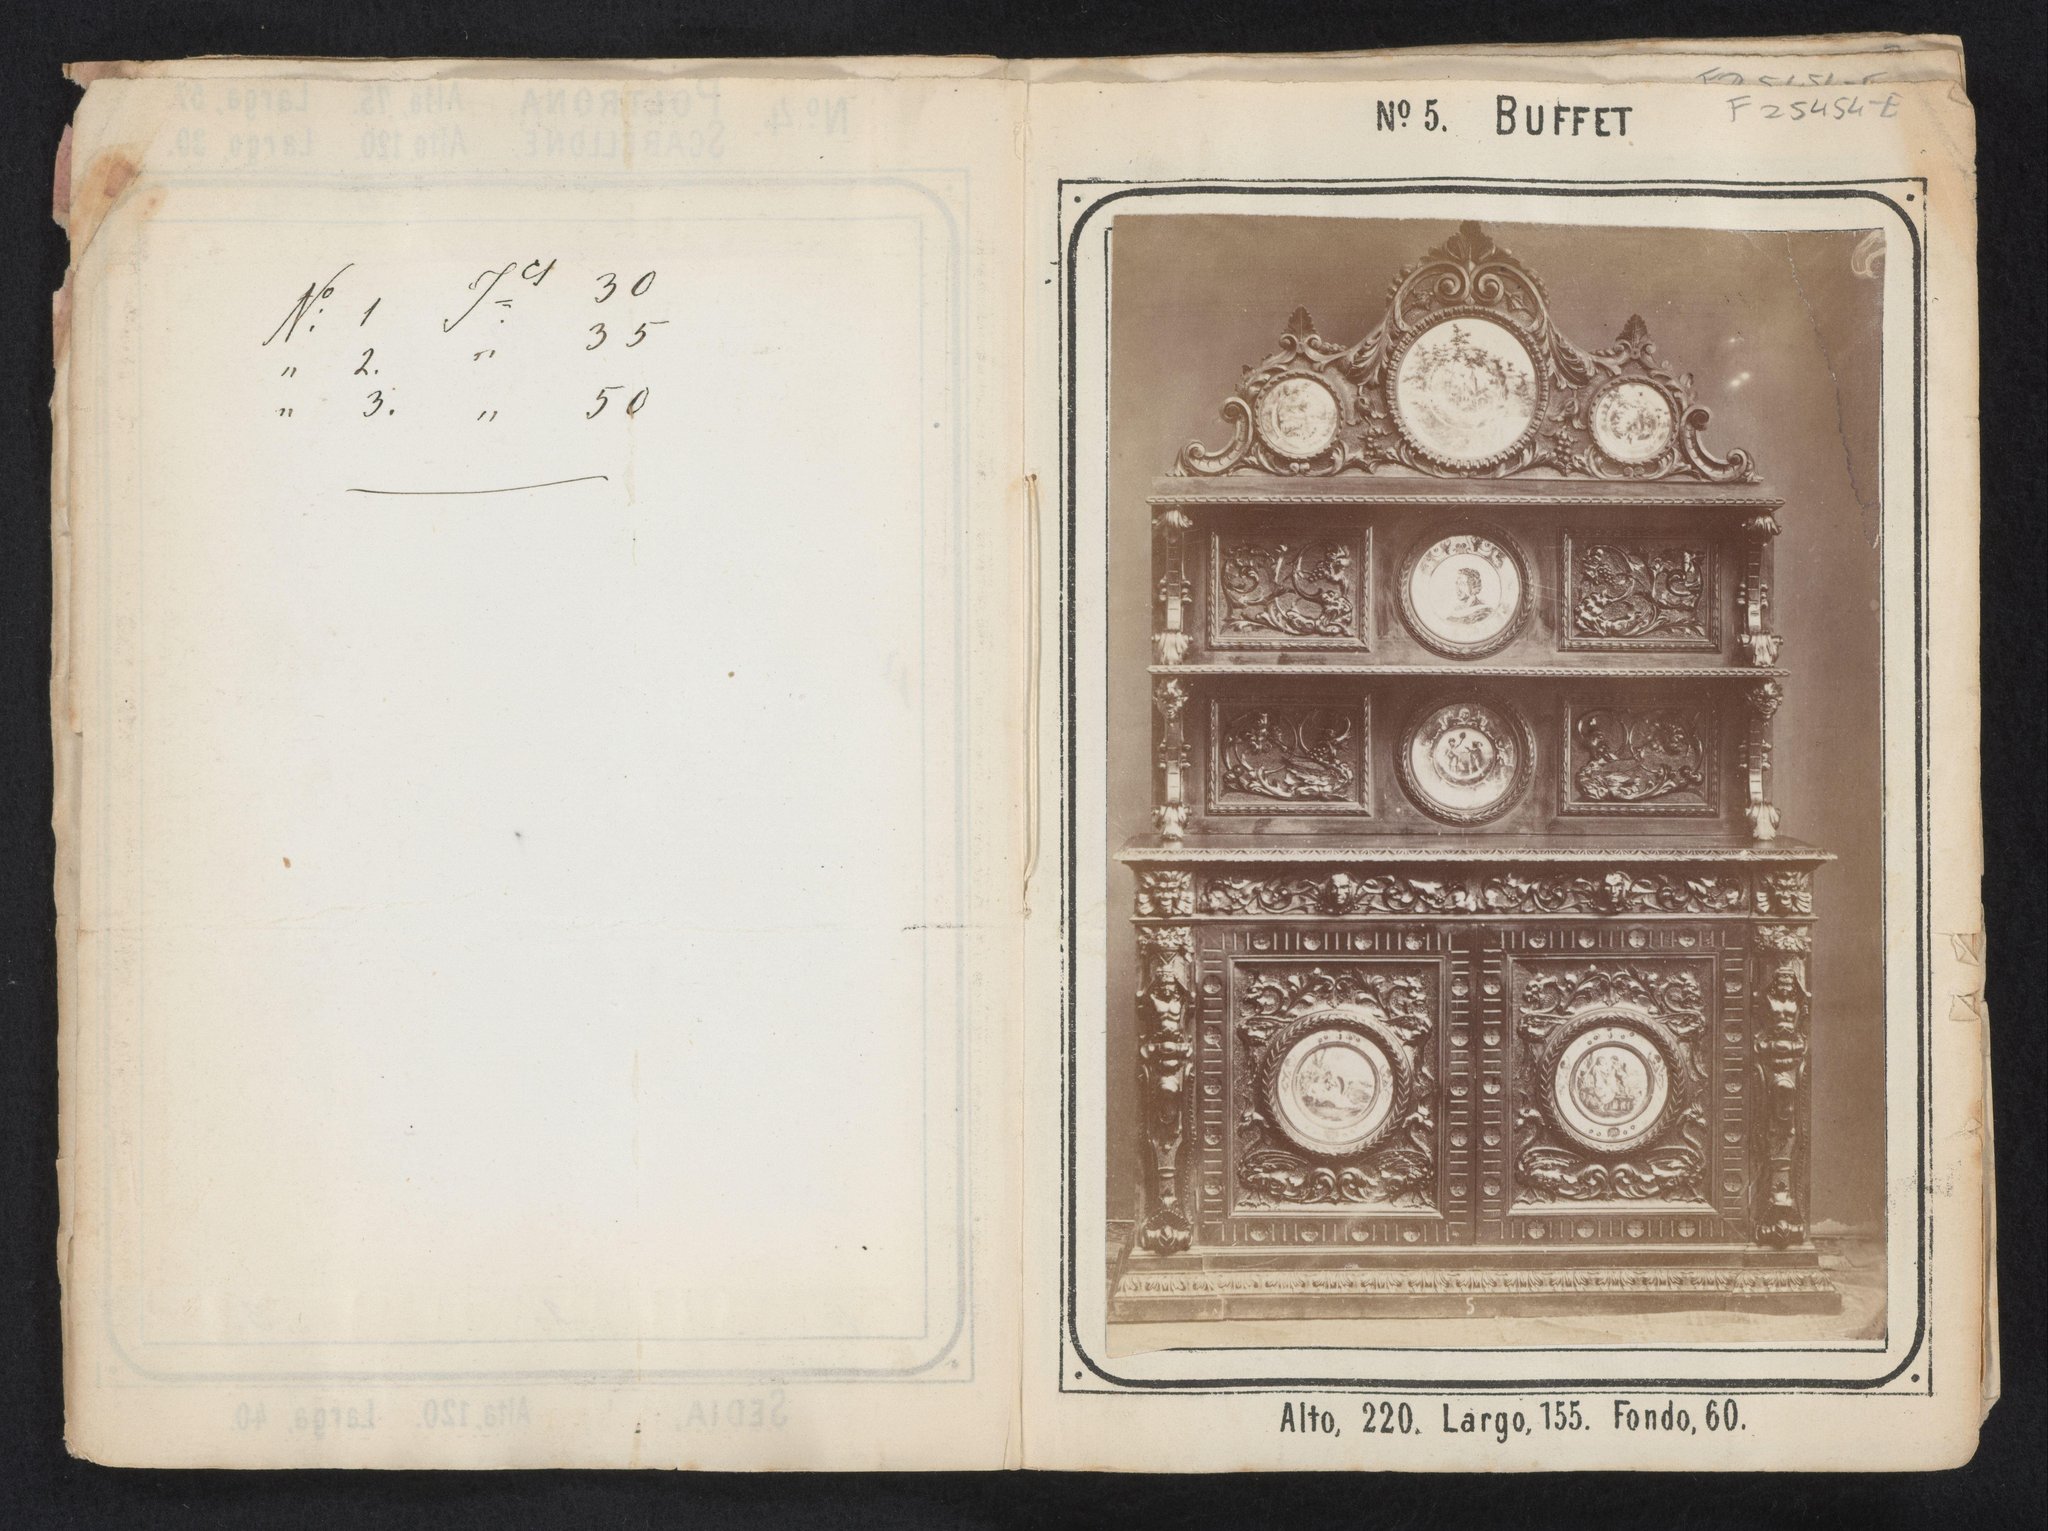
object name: page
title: Gedecoreerde buffetkast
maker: Anonymous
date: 1878-1885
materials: paper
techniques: albumen print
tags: ornamental cupboard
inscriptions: inscription: ‘Ies. 350’, inscription: ‘Alto, 220. Largo, 155. Fondo, 60.’